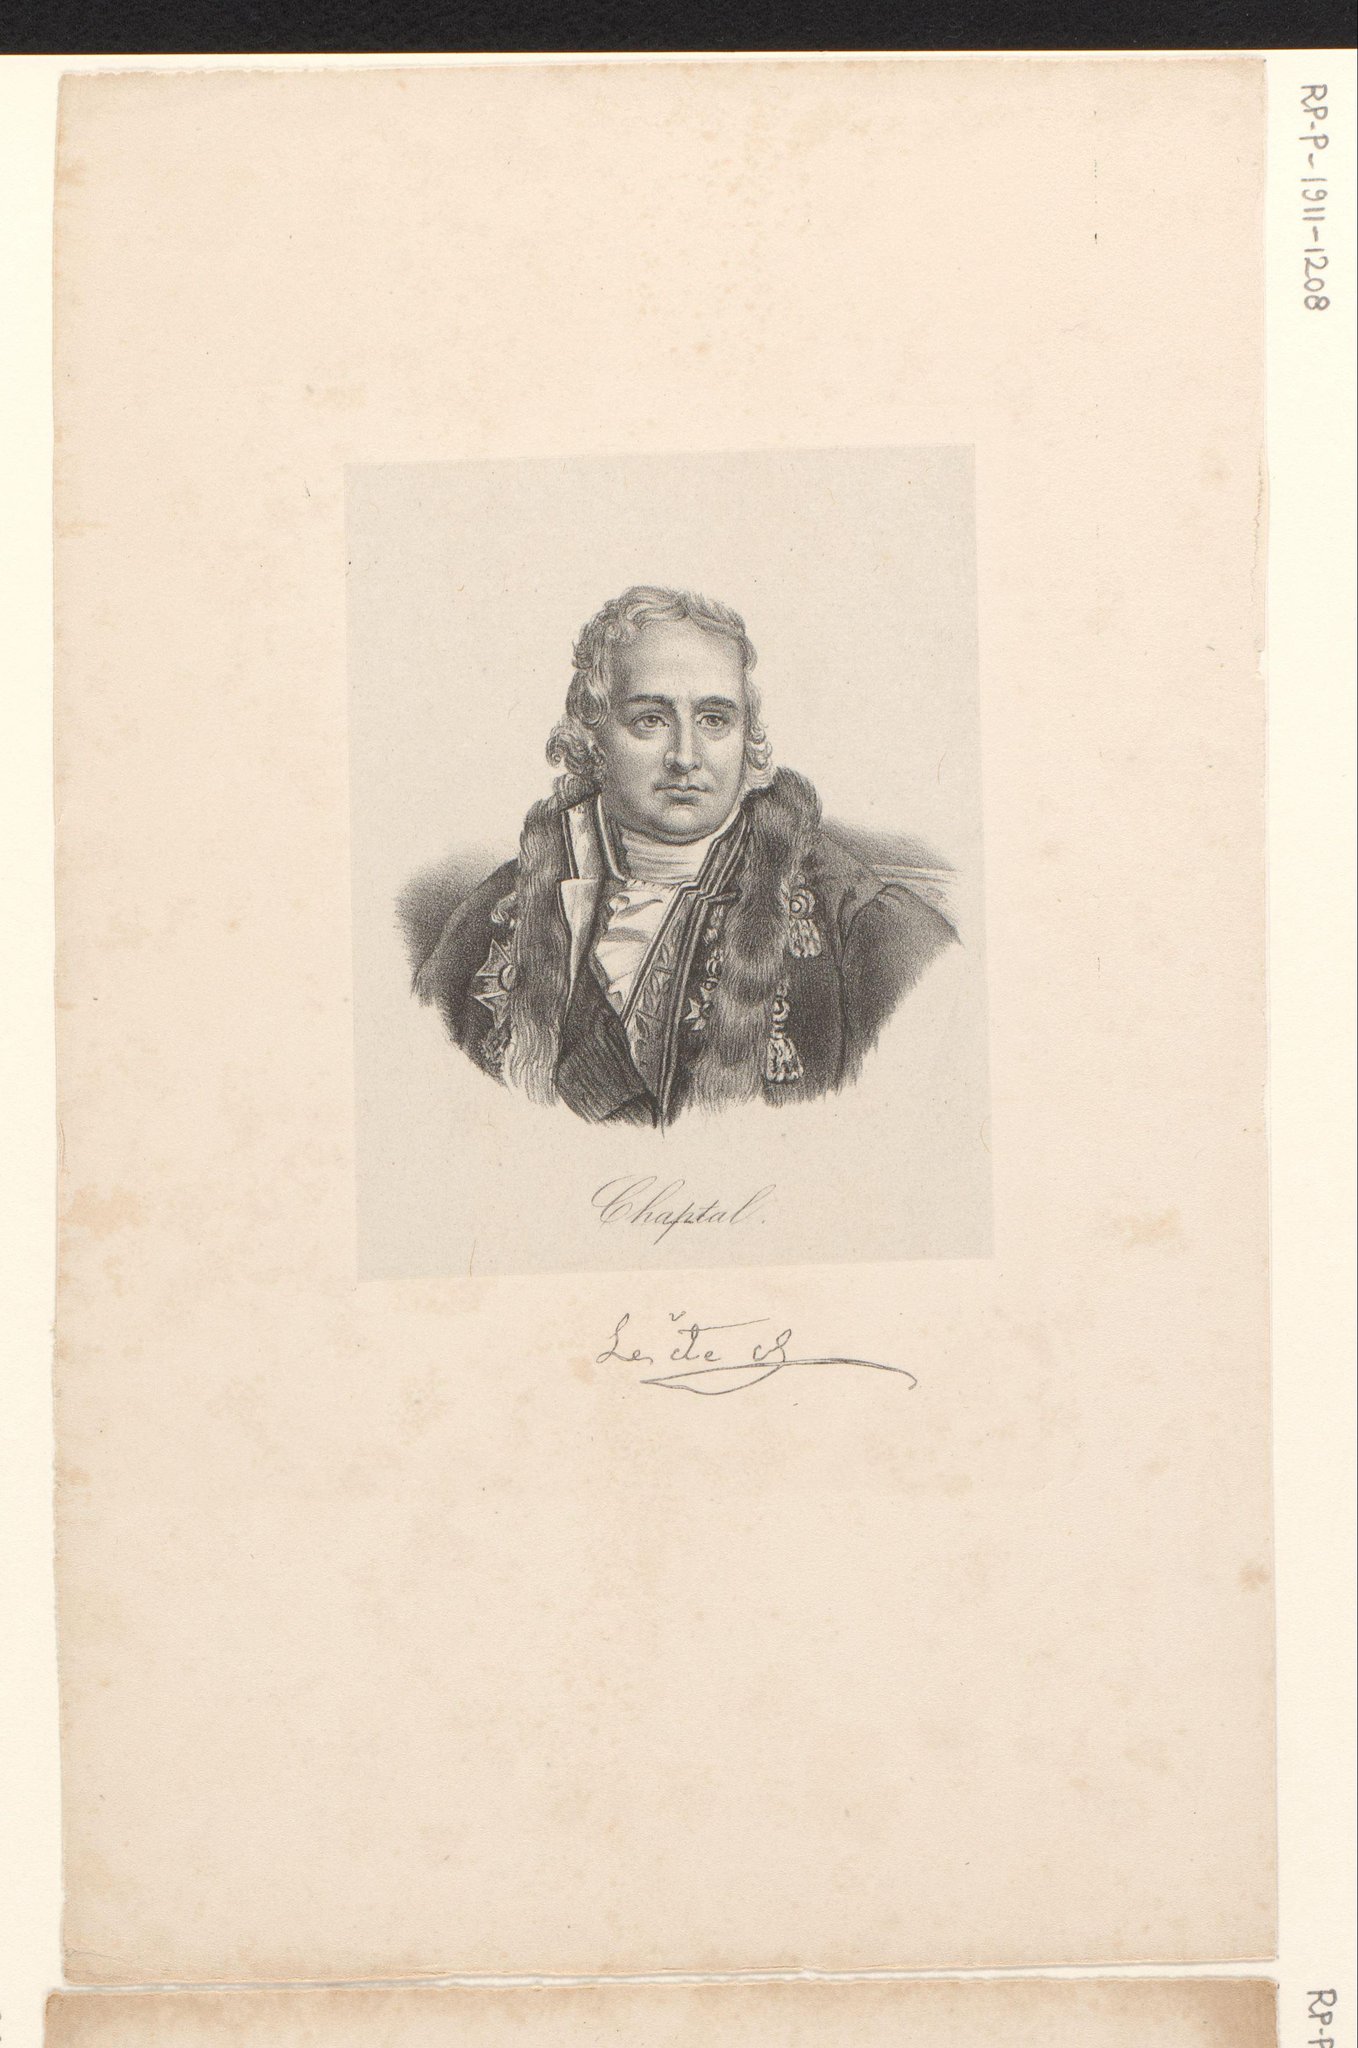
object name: print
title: Portret van Jean-Antoine Chaptal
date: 1818-1842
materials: paper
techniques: lithograph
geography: paris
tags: paris, politician, jean-antoine chaptal, historical persons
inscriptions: collector's mark: Lugt 2228a